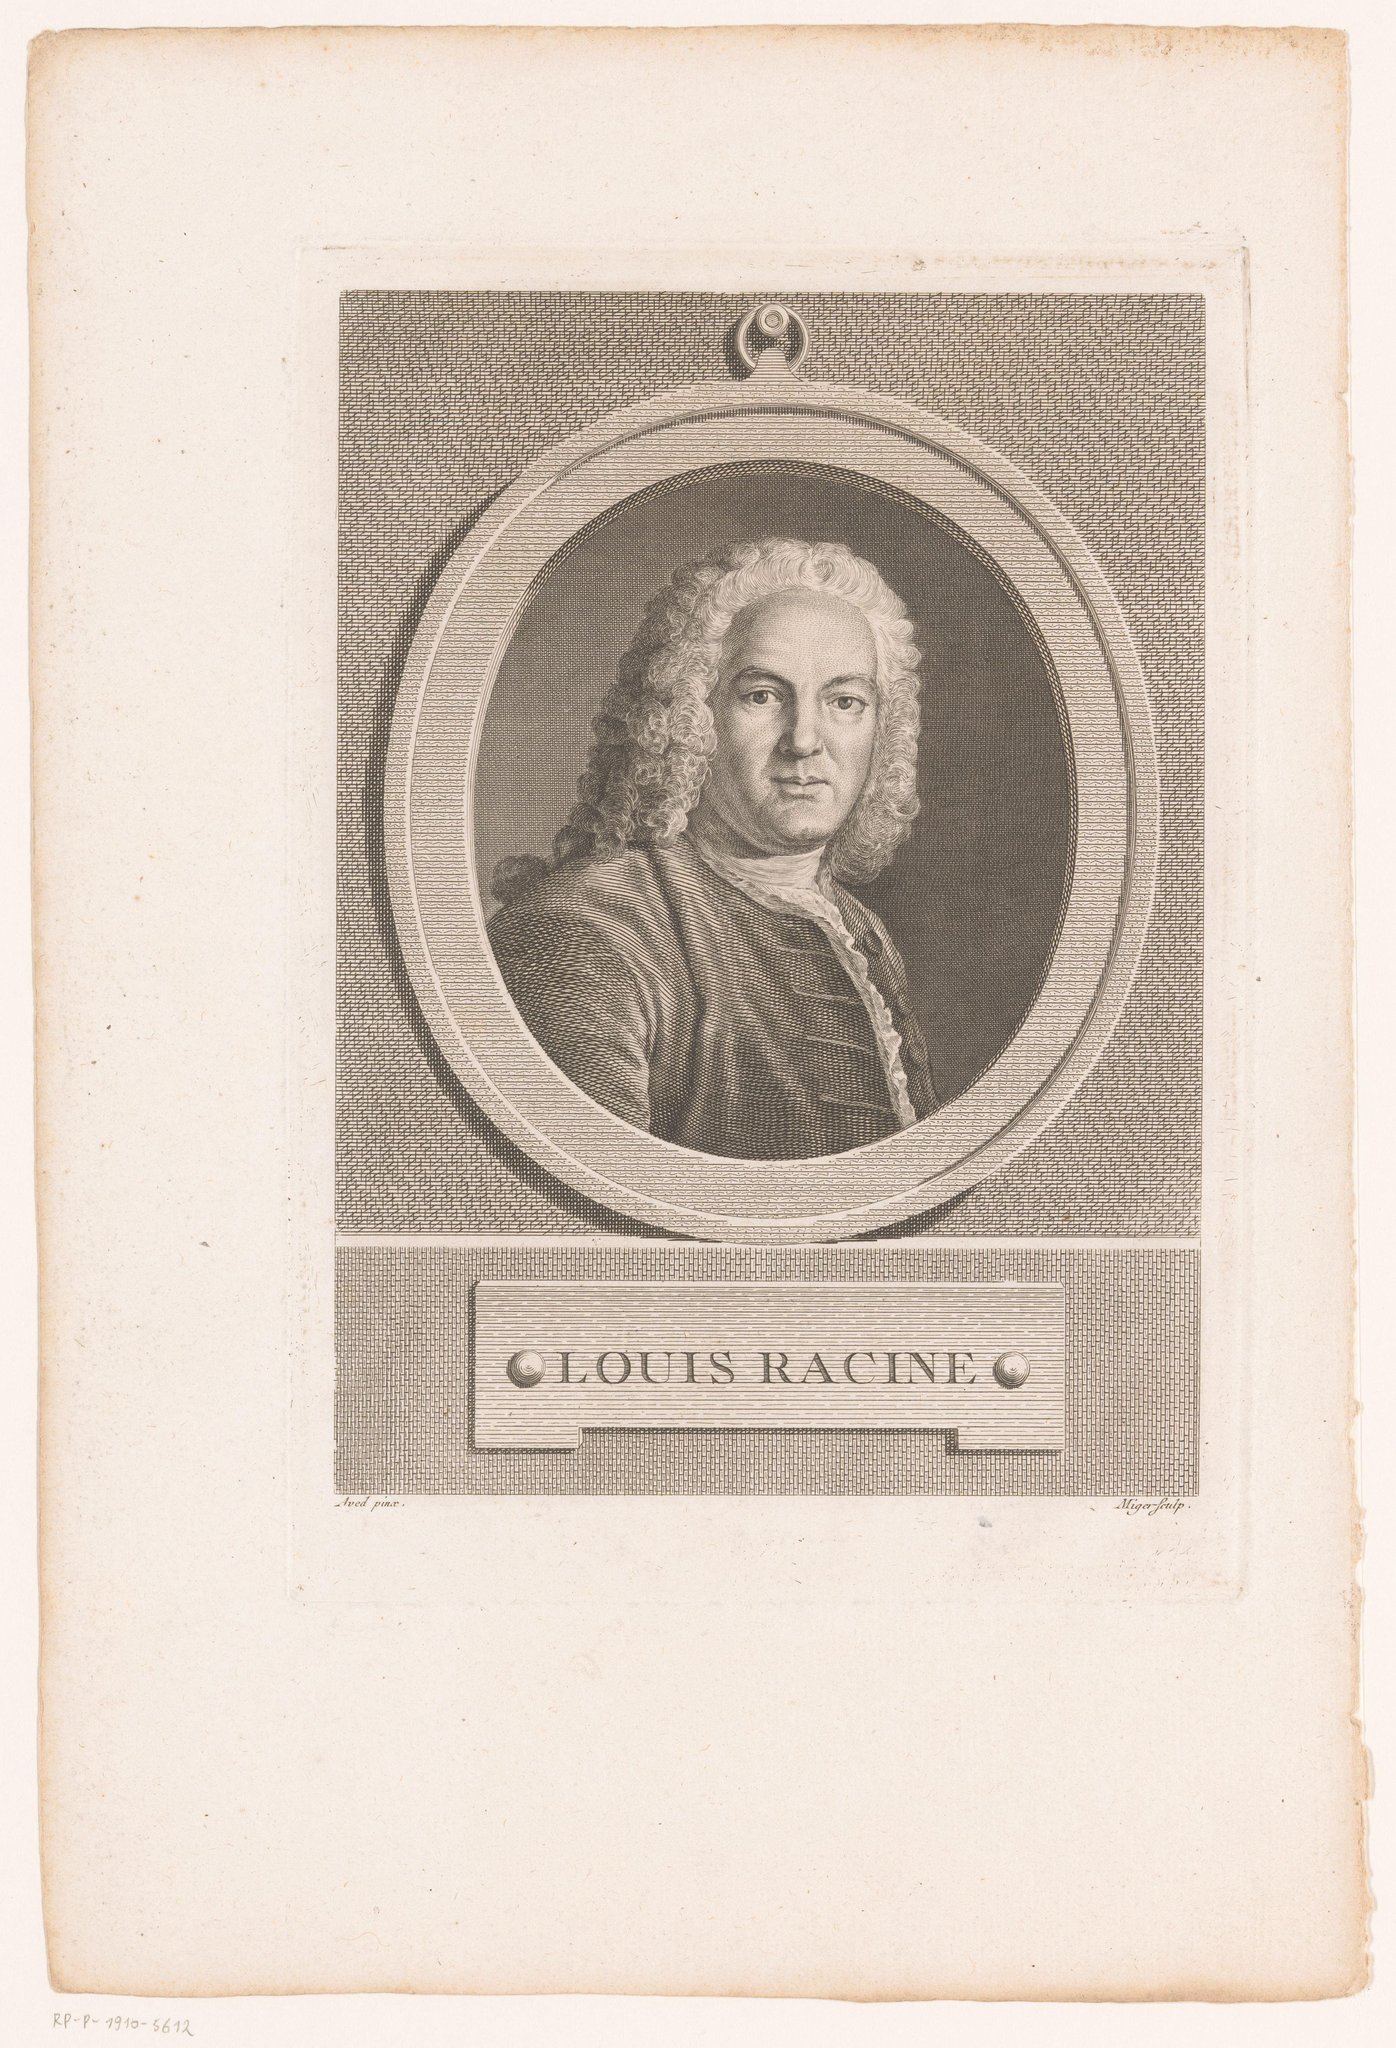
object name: print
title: Louis Racine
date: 1746-1820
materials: paper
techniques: engraving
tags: paris, historical persons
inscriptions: collector's mark: Lugt 2228